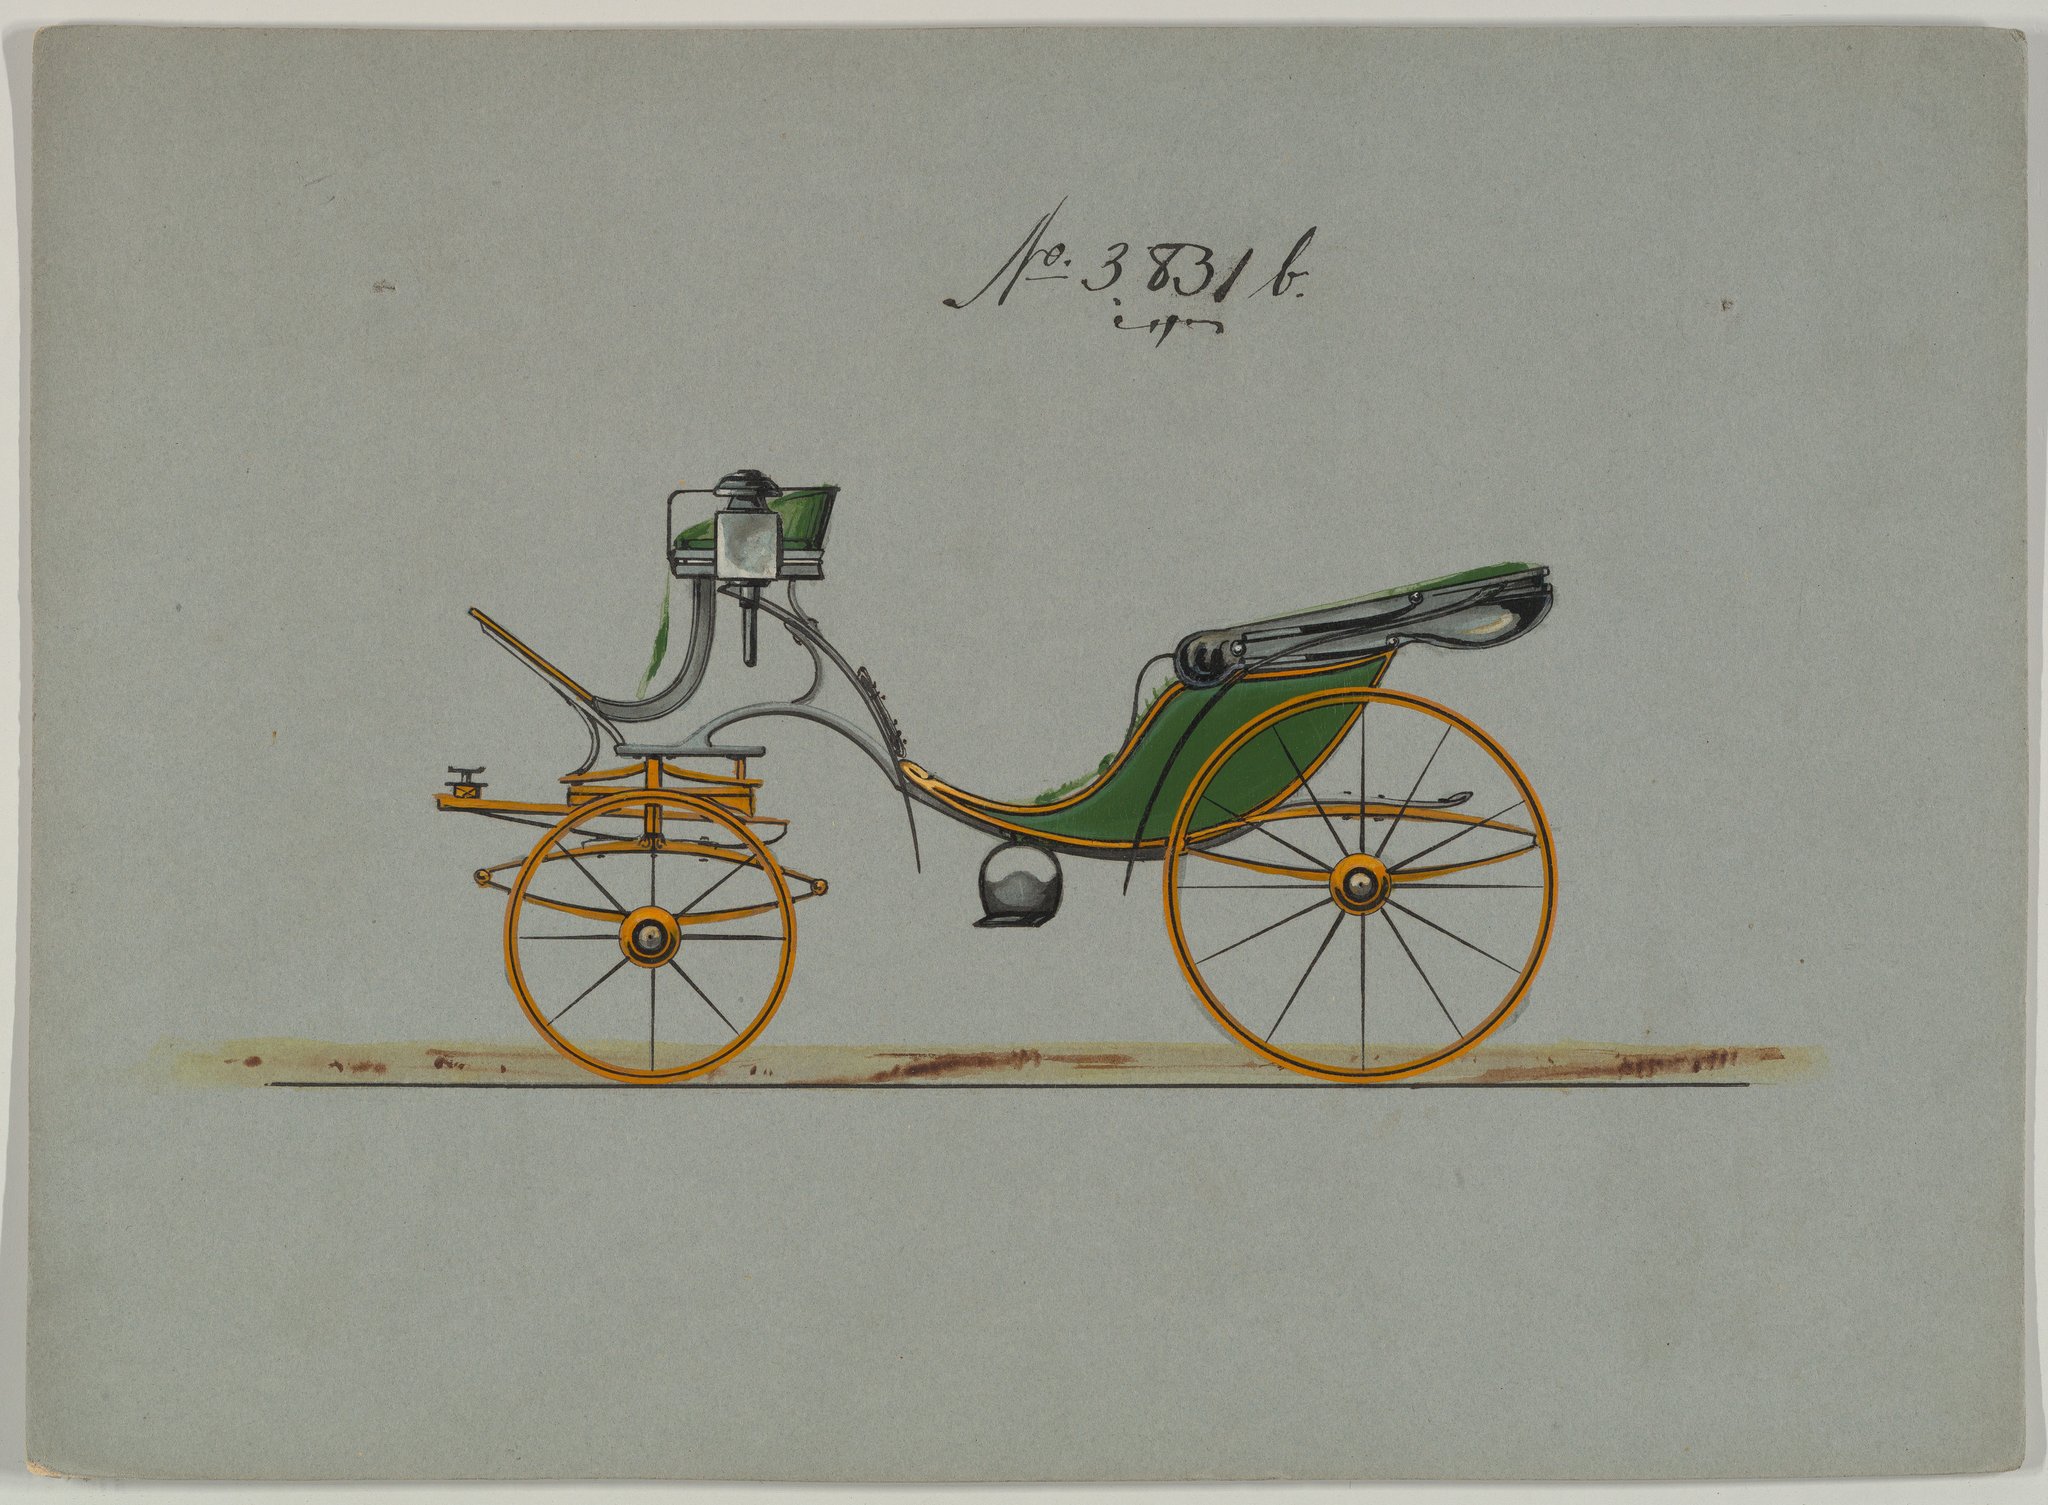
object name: drawing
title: Design for Cabriolet or Victoria, no. 3831b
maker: brewster & co.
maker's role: manufacturer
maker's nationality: american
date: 1883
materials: gouache, gum arabic, ink, watercolor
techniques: pen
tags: carriages